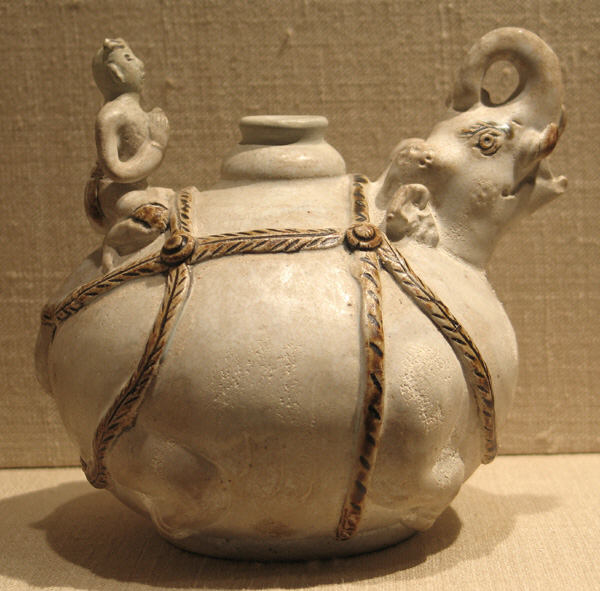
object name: vessel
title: Vessel in the form of an Elephant with Rider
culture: thai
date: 1301-1566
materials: earthenware, iron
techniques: underglaze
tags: men,elephants